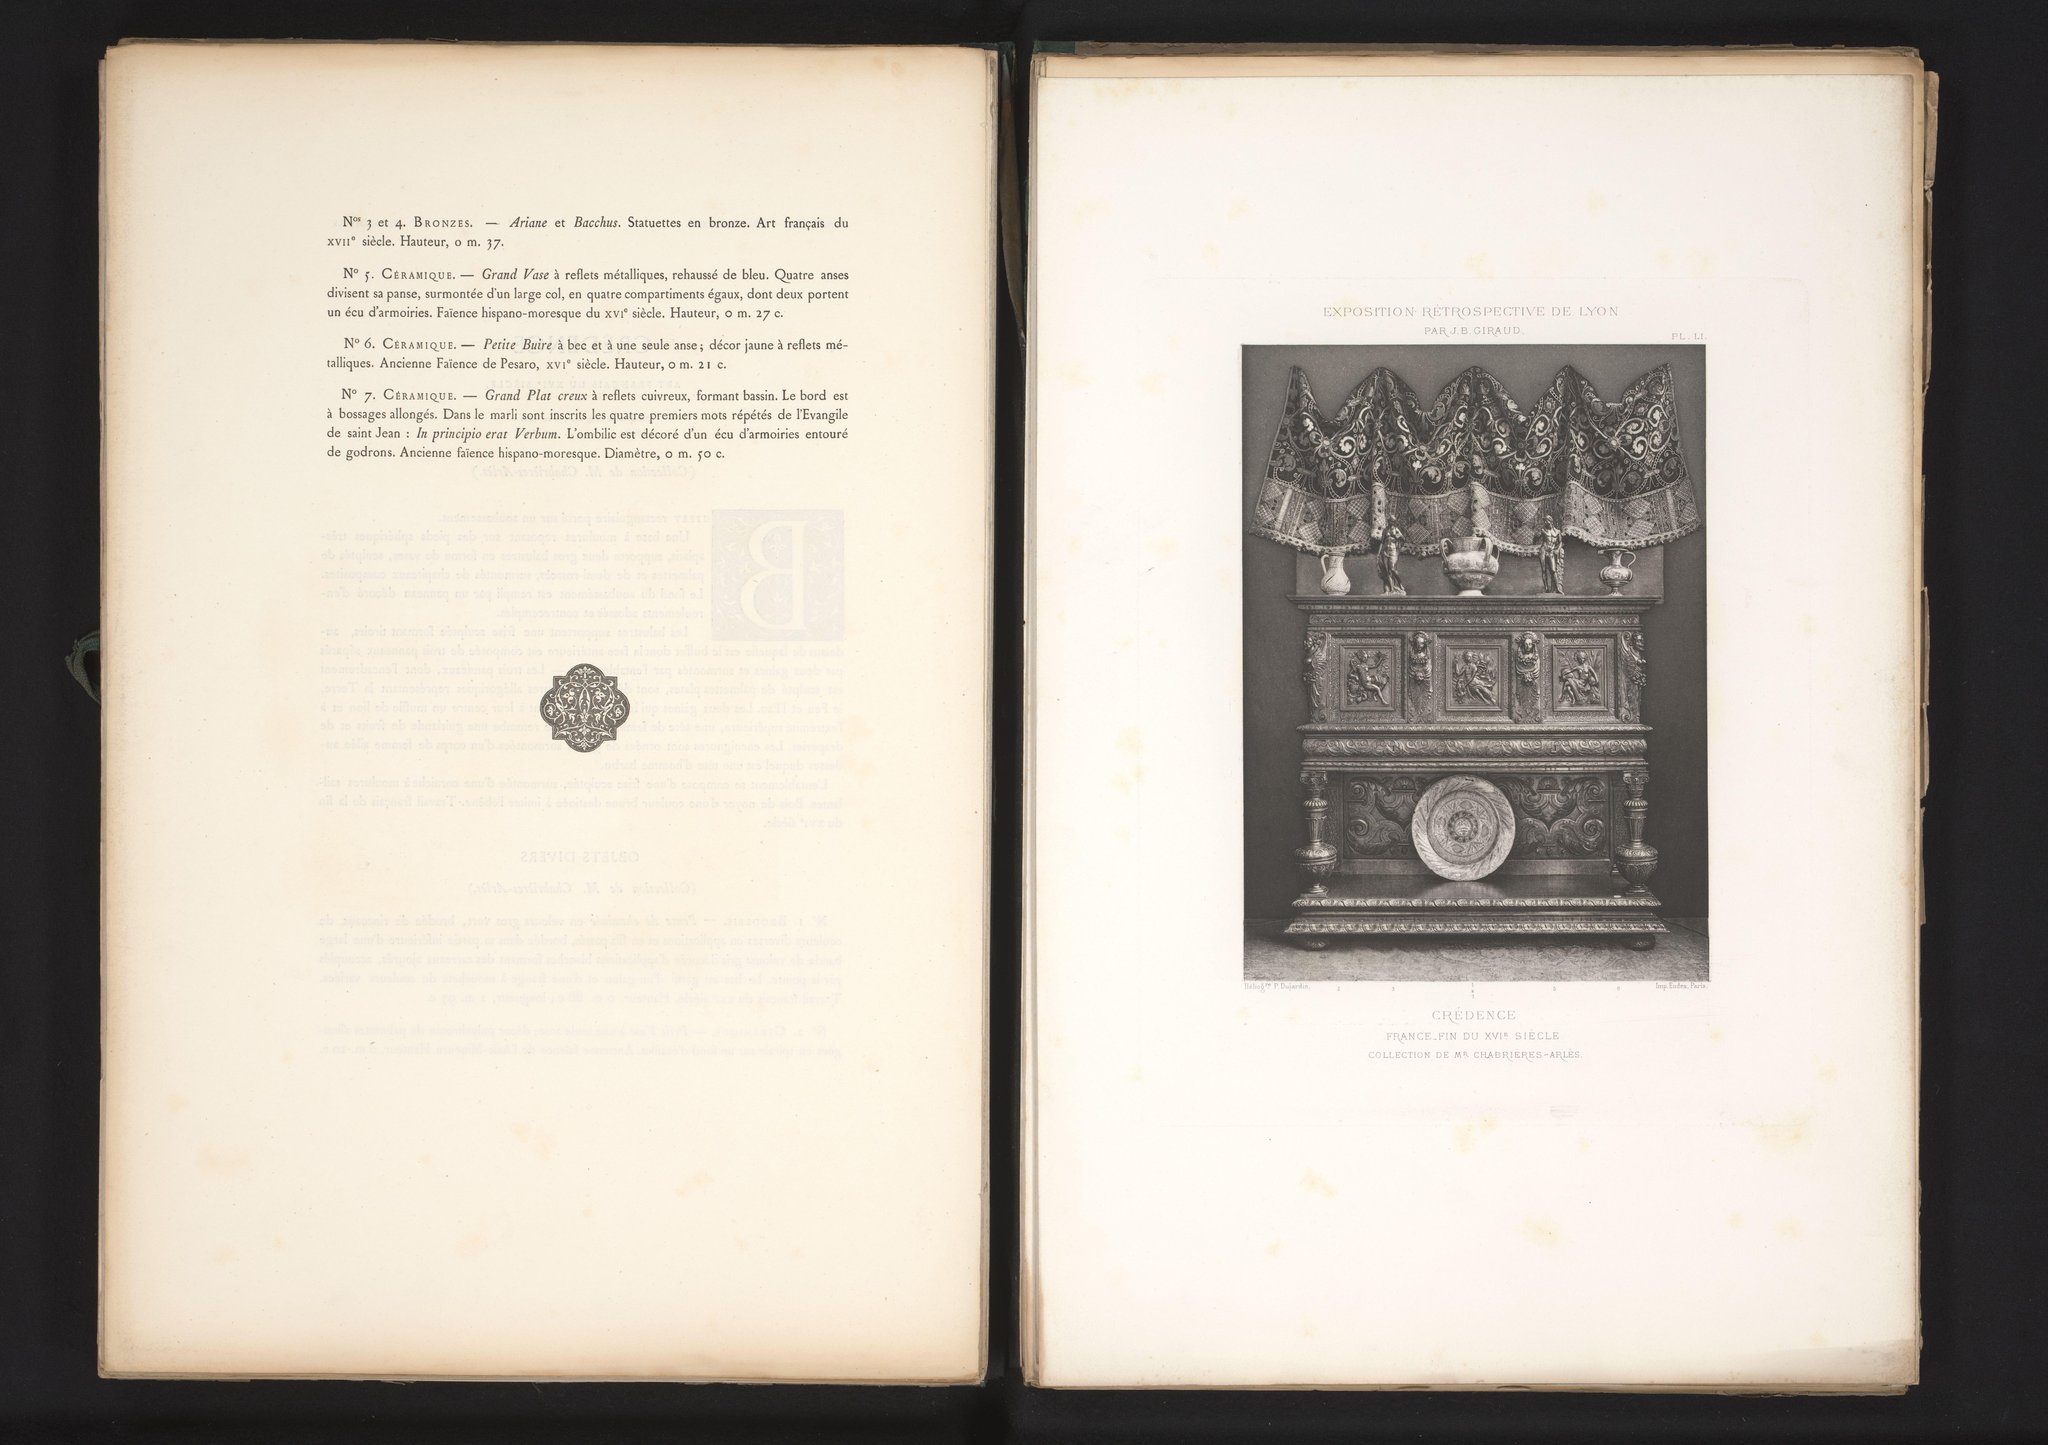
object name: photomechanical print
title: Laat-16de-eeuws Frans dressoir van hout, op de Exposition Rétrospective van 1877 in Lyon, Frankrijk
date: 1877-1878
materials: paper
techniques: photoaquatint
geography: lyon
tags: ornamental cupboard (+ wood and other phytogenic material), lyon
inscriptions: inscription: ‘EXPOSITION RÉTROSPECTIVE DE LYON/ PAR J. B. GIRAUD.’, inscription: ‘CRÉDENCE/ FRANCE_FIN DU XVIe SIÈCLE/ COLLECTION DE Mr CHABRIÈRES-ARLÈS.’, number: ‘PL. LI.’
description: Deze prent maakt deel uit van een omslag met 79 prenten op 54 bladen en 65 tekstbladen.